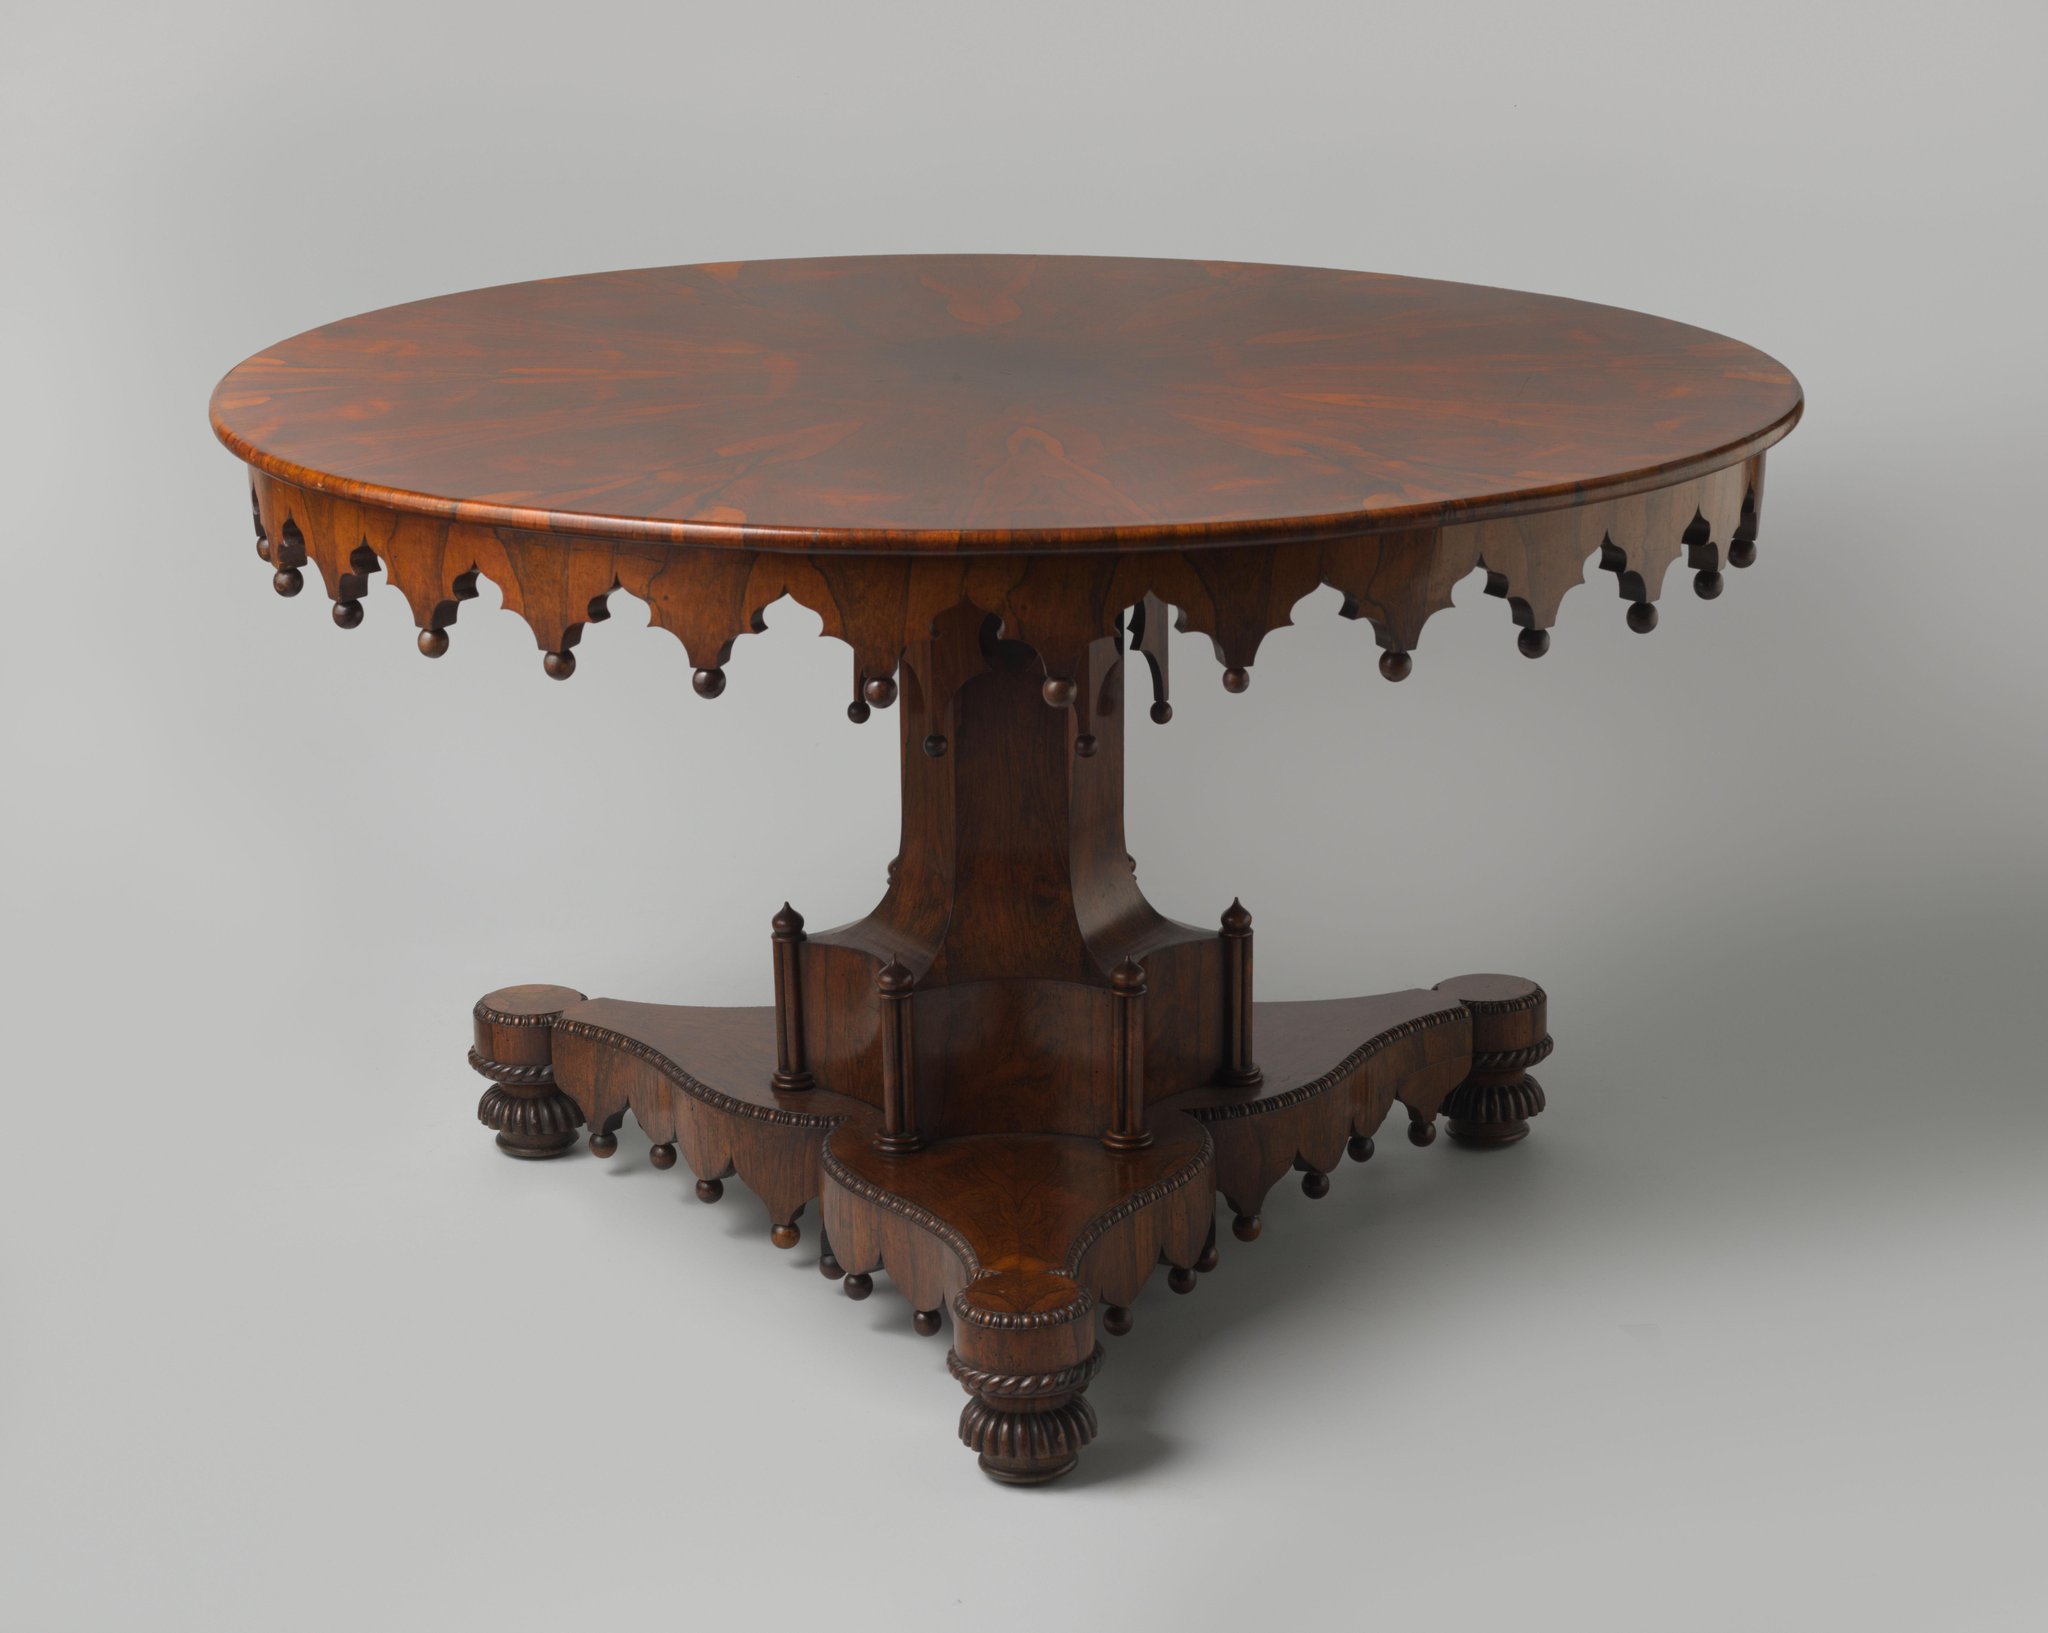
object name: furniture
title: Tafel met in segmenten gefineerd blad, op zeshoekige poot met sokkel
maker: Anonymous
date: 1840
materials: wood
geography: netherlands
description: Table. Various woods, veneered with rosewood. Netherlands, c. 1840. Acquired with funds from the Belport Familienstiftung, 1982.